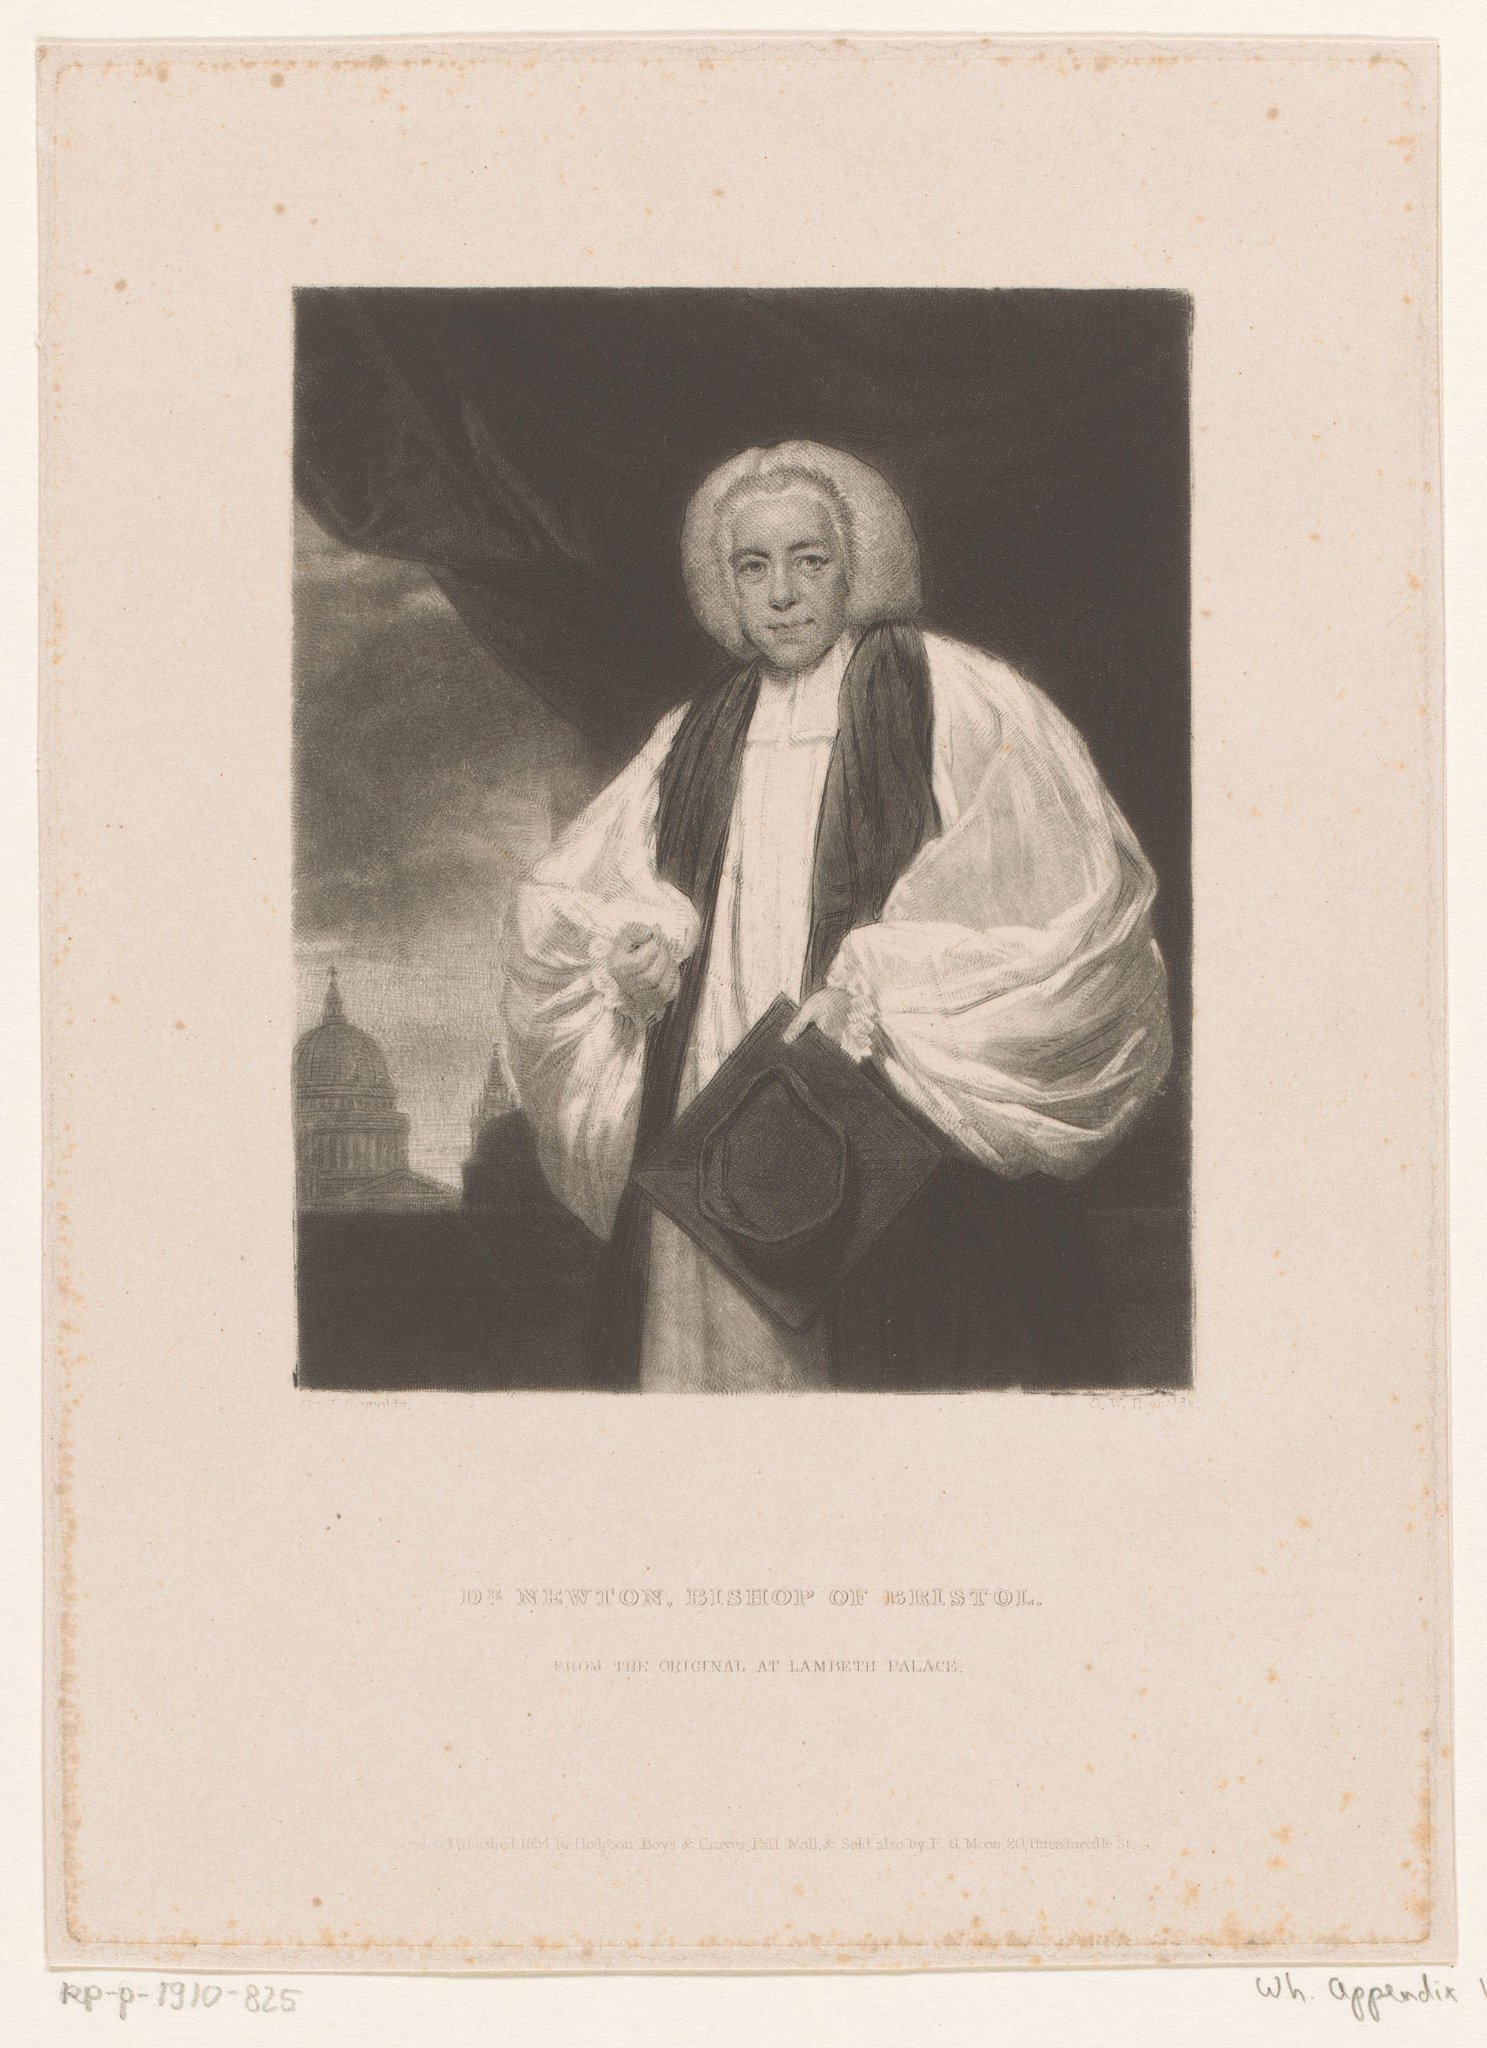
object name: print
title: Portret van Thomas Newton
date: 1834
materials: paper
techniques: engraving, etching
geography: london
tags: london, thomas newton, archbishop, bishop, etc. (roman catholic), historical persons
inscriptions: collector's mark: Lugt 2228